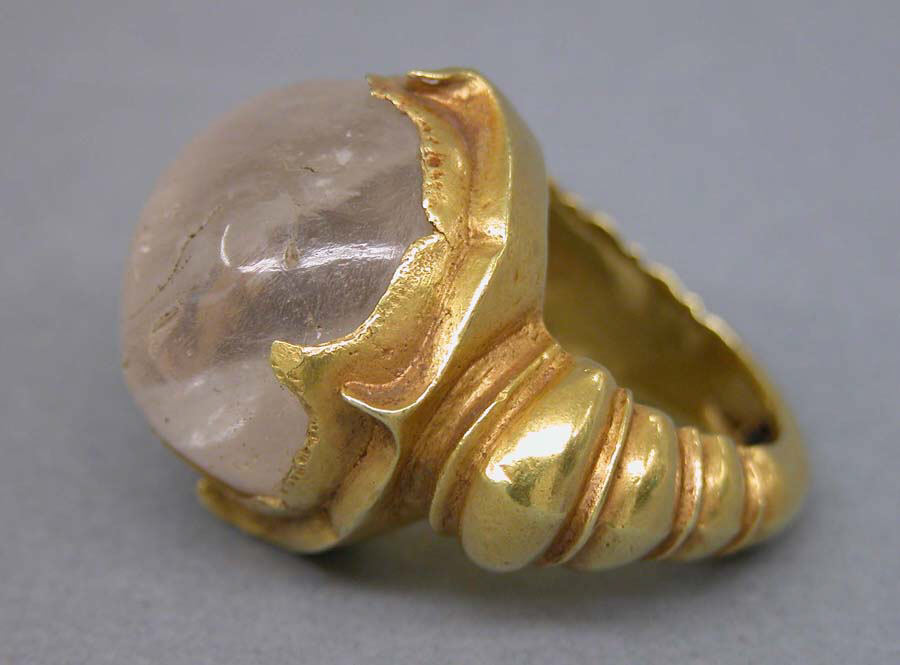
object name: ring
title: Ring with Circular Clear Stone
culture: indonesian, javanese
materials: gold, stone